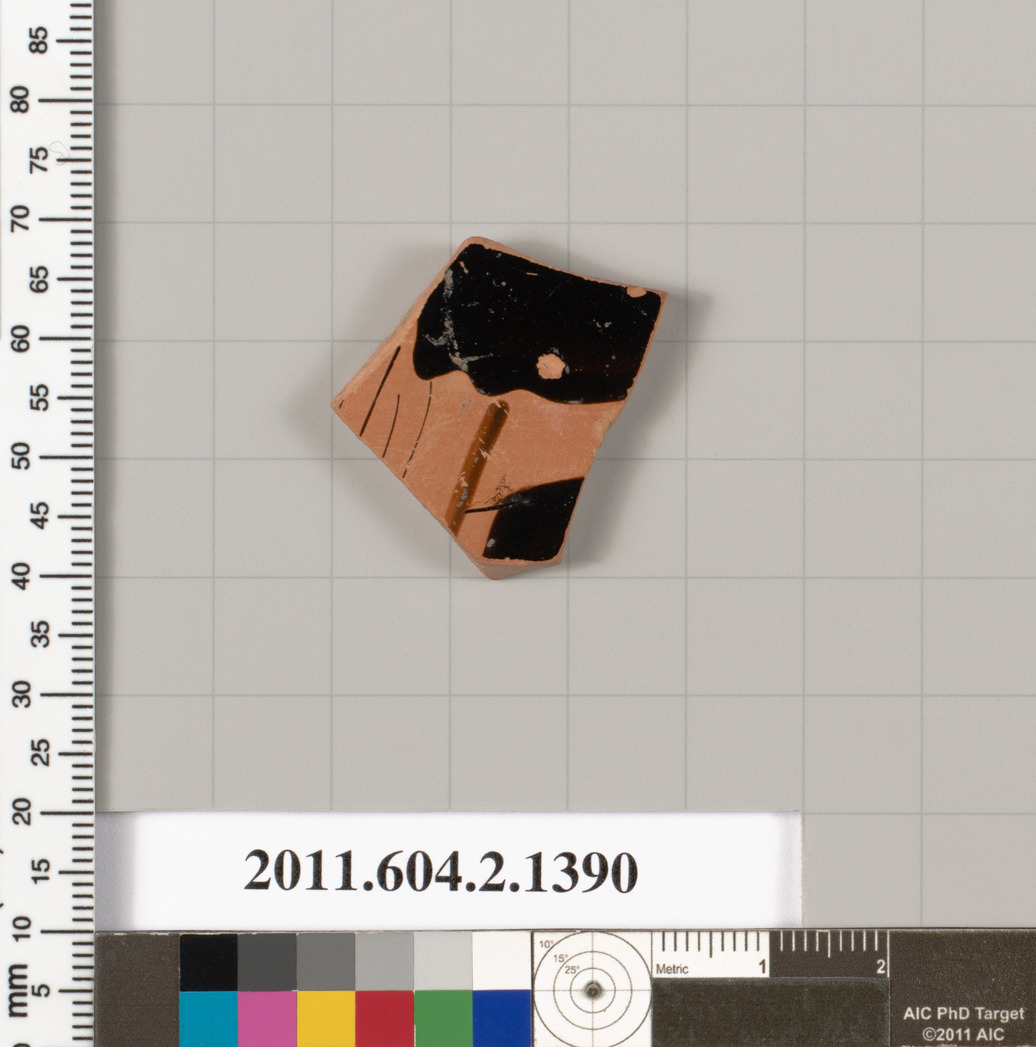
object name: skyphos fragment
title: Terracotta fragment of a skyphos (deep drinking cup)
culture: greek, attic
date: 450-426 BCE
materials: terracotta